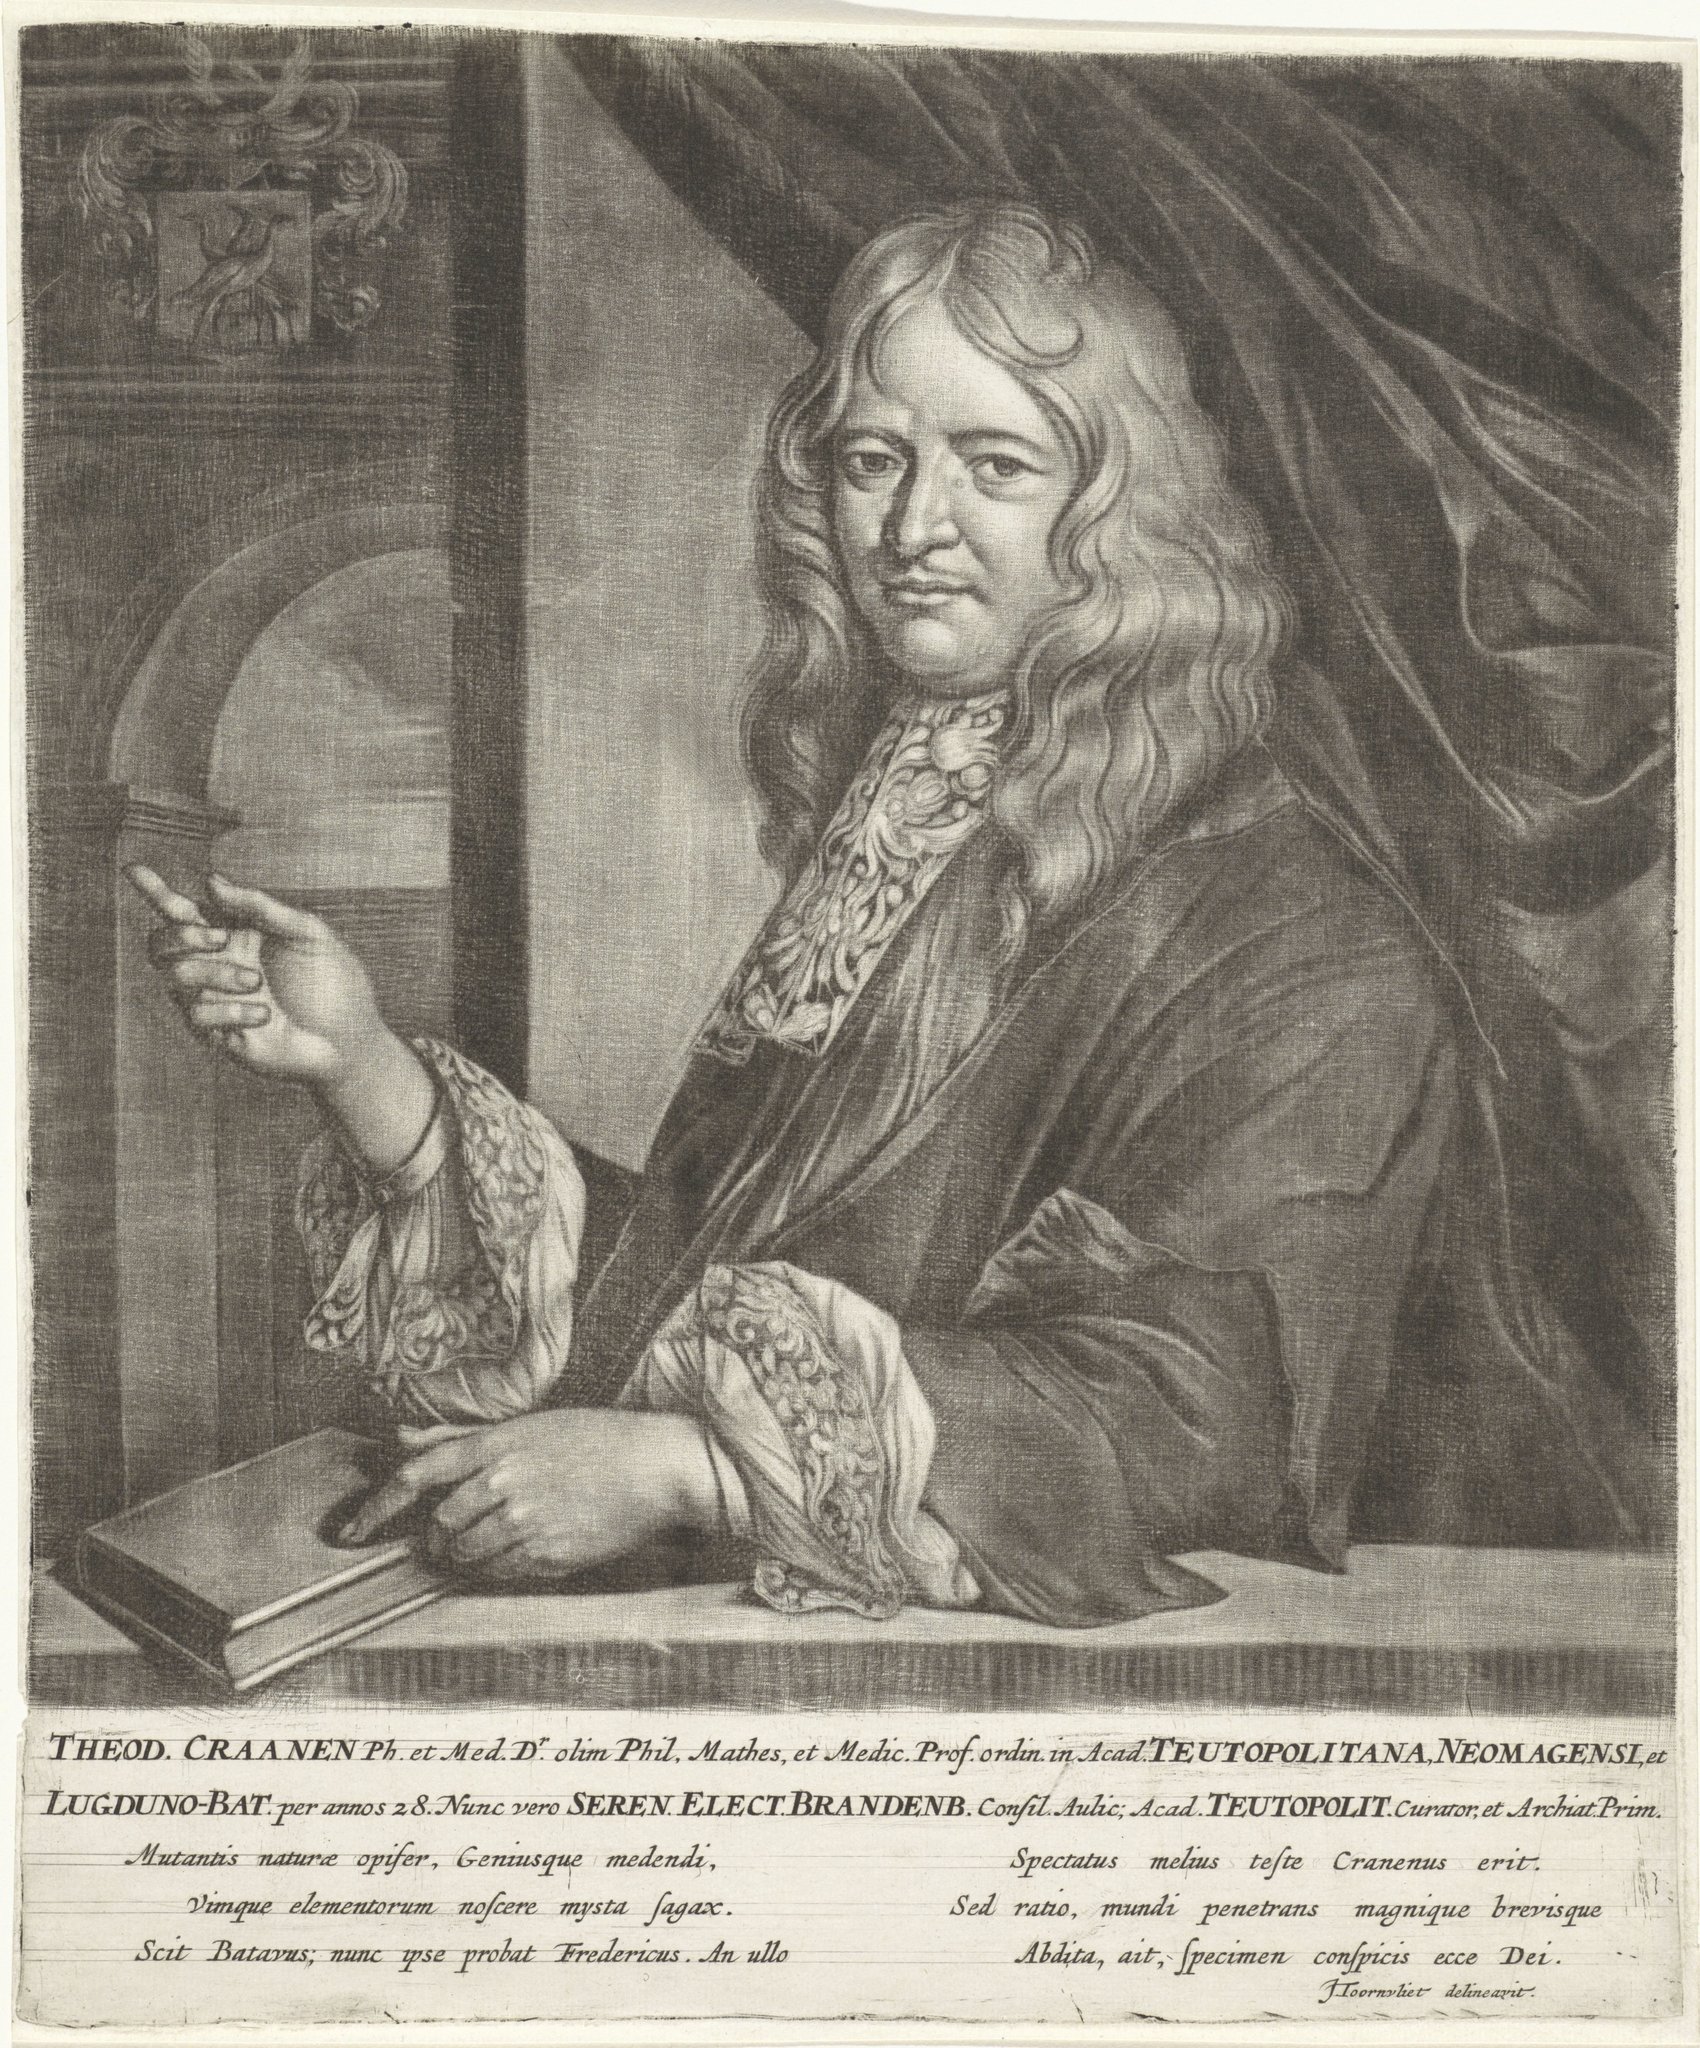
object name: print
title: Portret van Theodorus Craanen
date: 1651-1719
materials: paper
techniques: engraving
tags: physician, doctor, book, armorial bearing, heraldry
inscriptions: collector's mark: Lugt 2228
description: De Leidse hoogleraar medicijnen en wijsbegeerte Theodorus Craanen. Craanen werd in 1687 lijfarts van de Duitse keurvorst Friedrich Wilhelm van Brandenburg. Hij heeft een boek onder zijn hand.